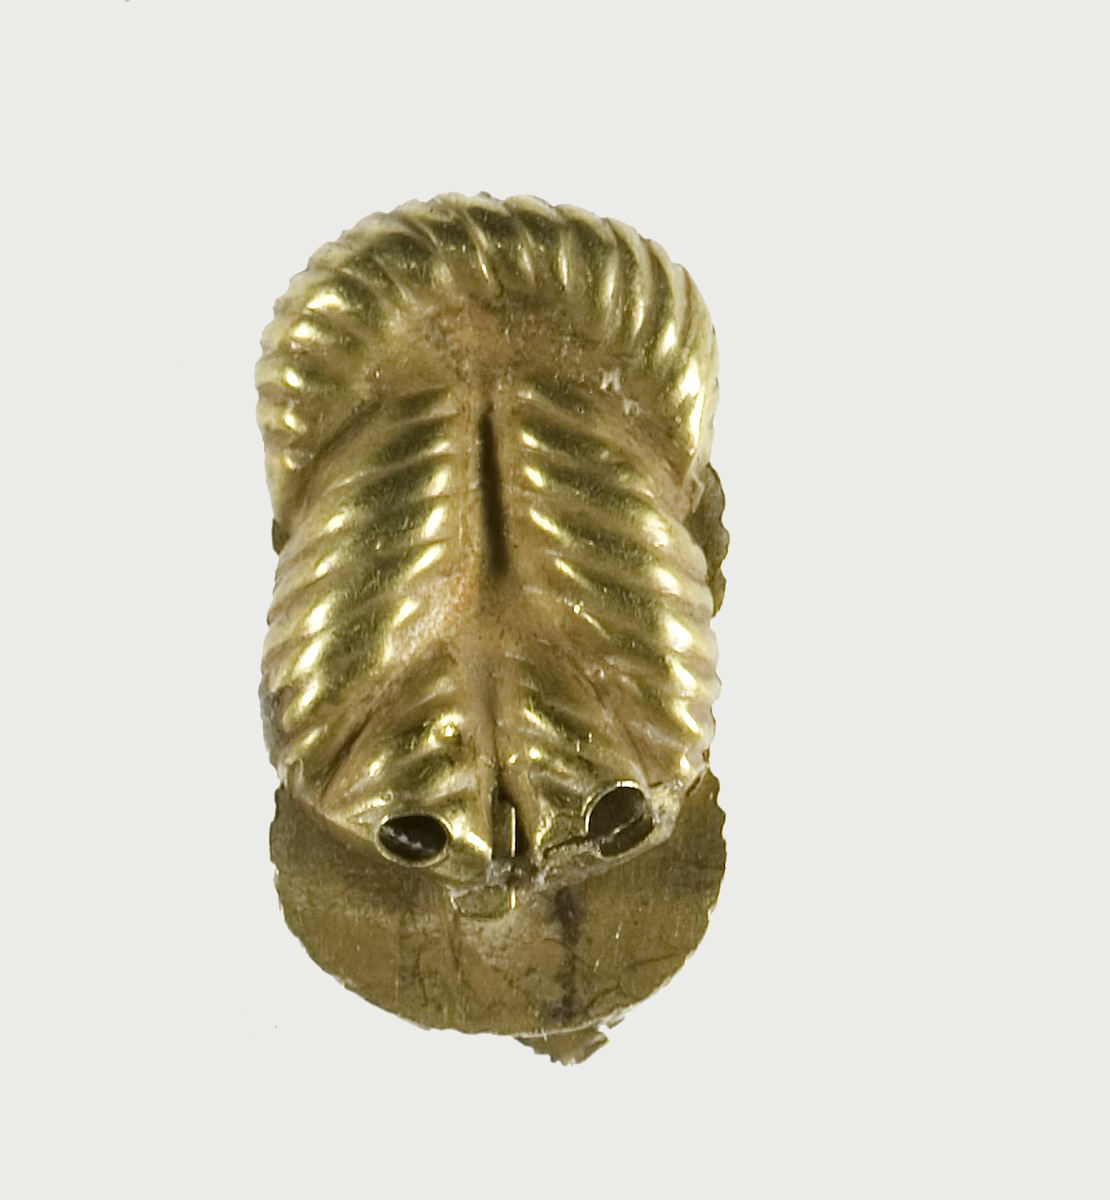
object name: clasp, sithathoryunet, double knot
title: Double knot clasp of Sithathoryunet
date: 1887-1813 BCE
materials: gold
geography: egypt